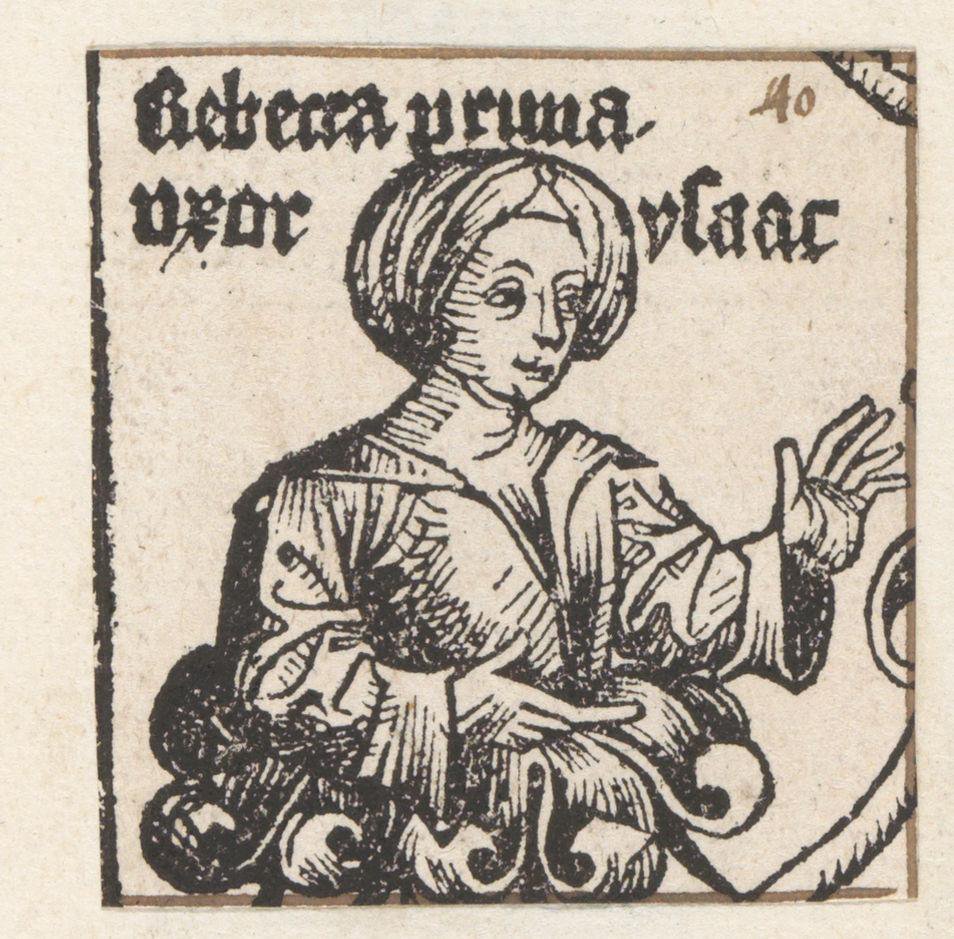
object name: album leaf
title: Rebekka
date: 1493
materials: paper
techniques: letterpress printing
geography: nuremberg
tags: persons from the old testament (not in biblical context, nor occurring in legendary/historical extensions included in division 71)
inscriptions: inscription: ‘40’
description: Een bloemkelk met een vrouw, naar rechts gekeerd. De tekst identificeert haar als Rebekka, de eerste vrouw van Isaak. De voorstelling is een fragment van de stamboom van Christus in de Liber Chronicarum. De prent maakt deel uit van een album.